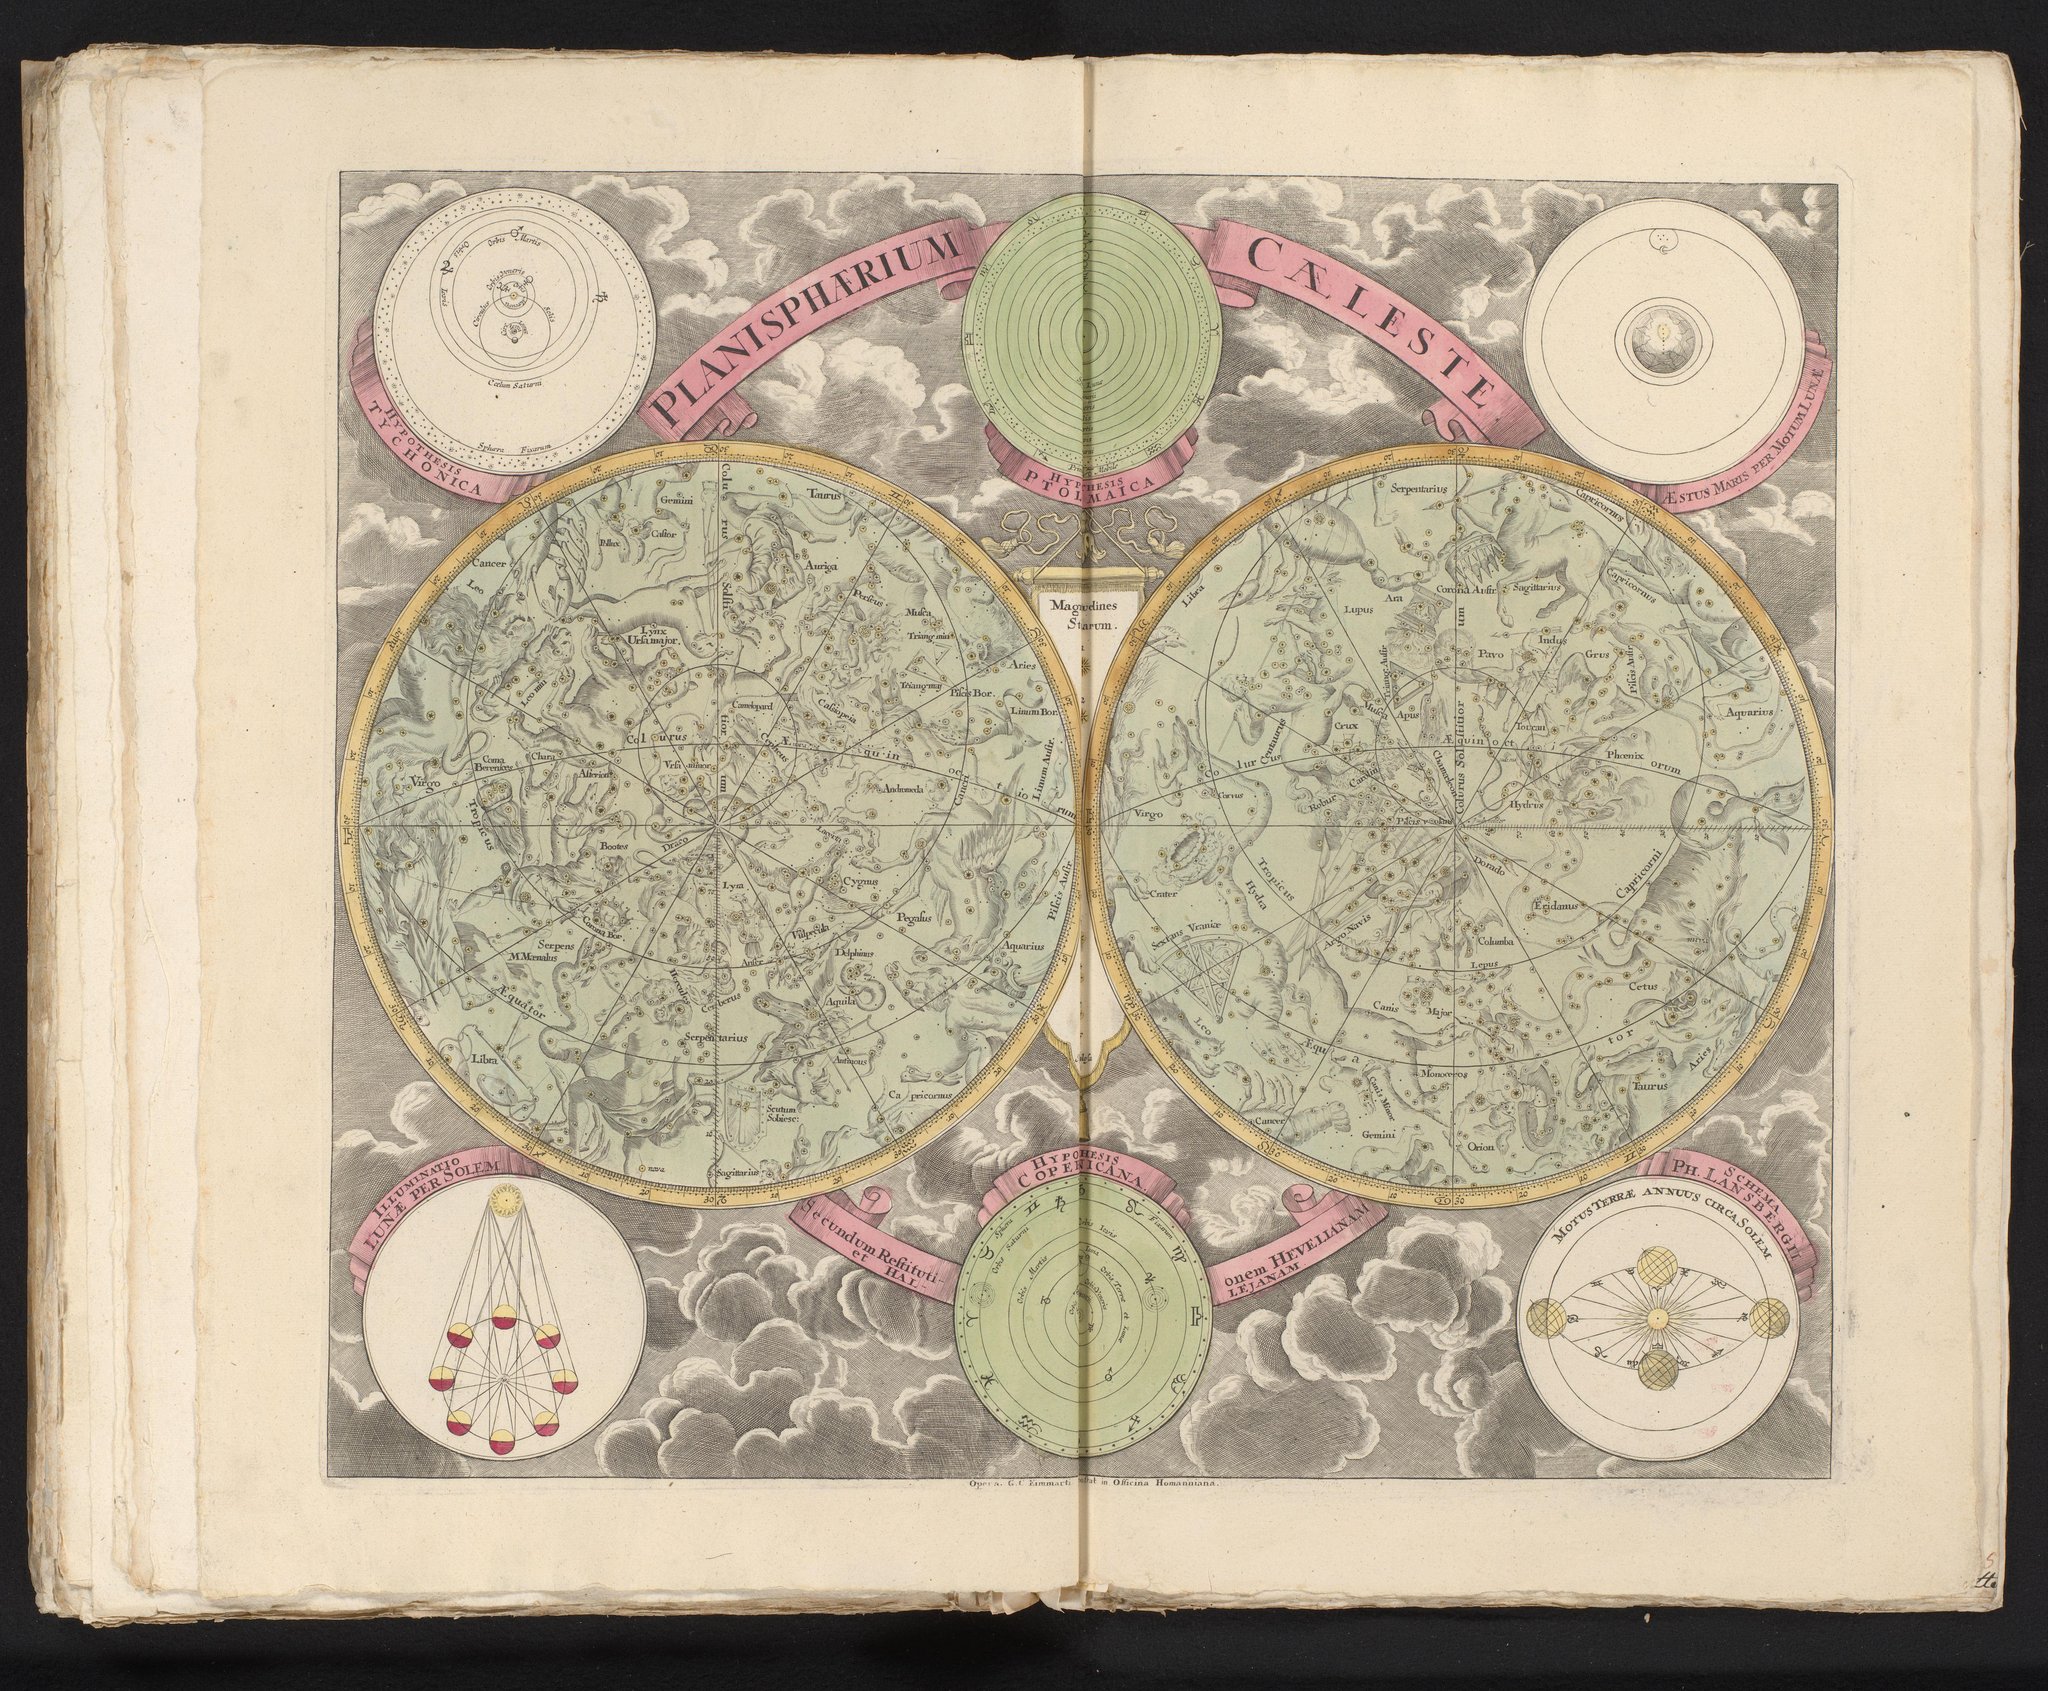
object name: print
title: Hemelkaart met de noordelijke en zuidelijke sterrenbeelden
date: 1707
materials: paper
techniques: engraving, etching, hand coloring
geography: nuremberg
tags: full moon, sun as celestial body, zodiac; the twelve zodiacal signs together, solar eclipse, star-chart, star map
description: Hemelkaart met de noordelijke en zuidelijke sterrenbeelden. Boven, van links naar rechts, weergaven van het stelsel van Tycho Brahe, het stelsel van Ptolemaeus en het effect van de maan op het getijde. Onder, van links naar rechts, weergaven van de schijngestalten van de maan, het stelsel van Nicolaas Copernicus en de stand van de aarde tijdens het draaien om de zon, volgens Philippus Lansbergen.